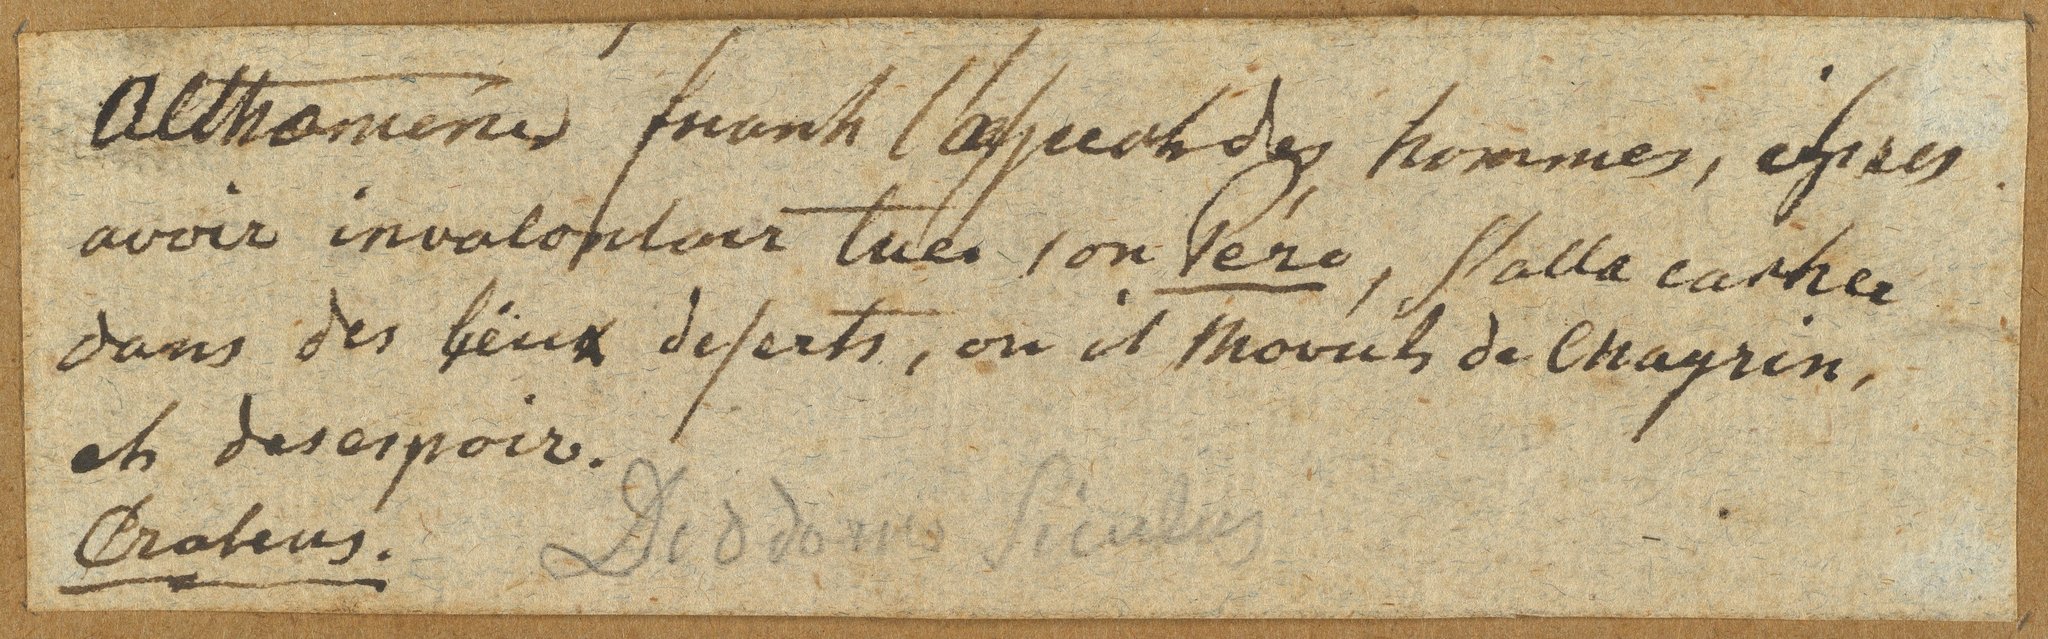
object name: note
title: Notes on the story of Althaemenes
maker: nicolai abraham abildgaard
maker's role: artist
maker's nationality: danish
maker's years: 1743-1809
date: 1734-1833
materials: graphite, ink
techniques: pen